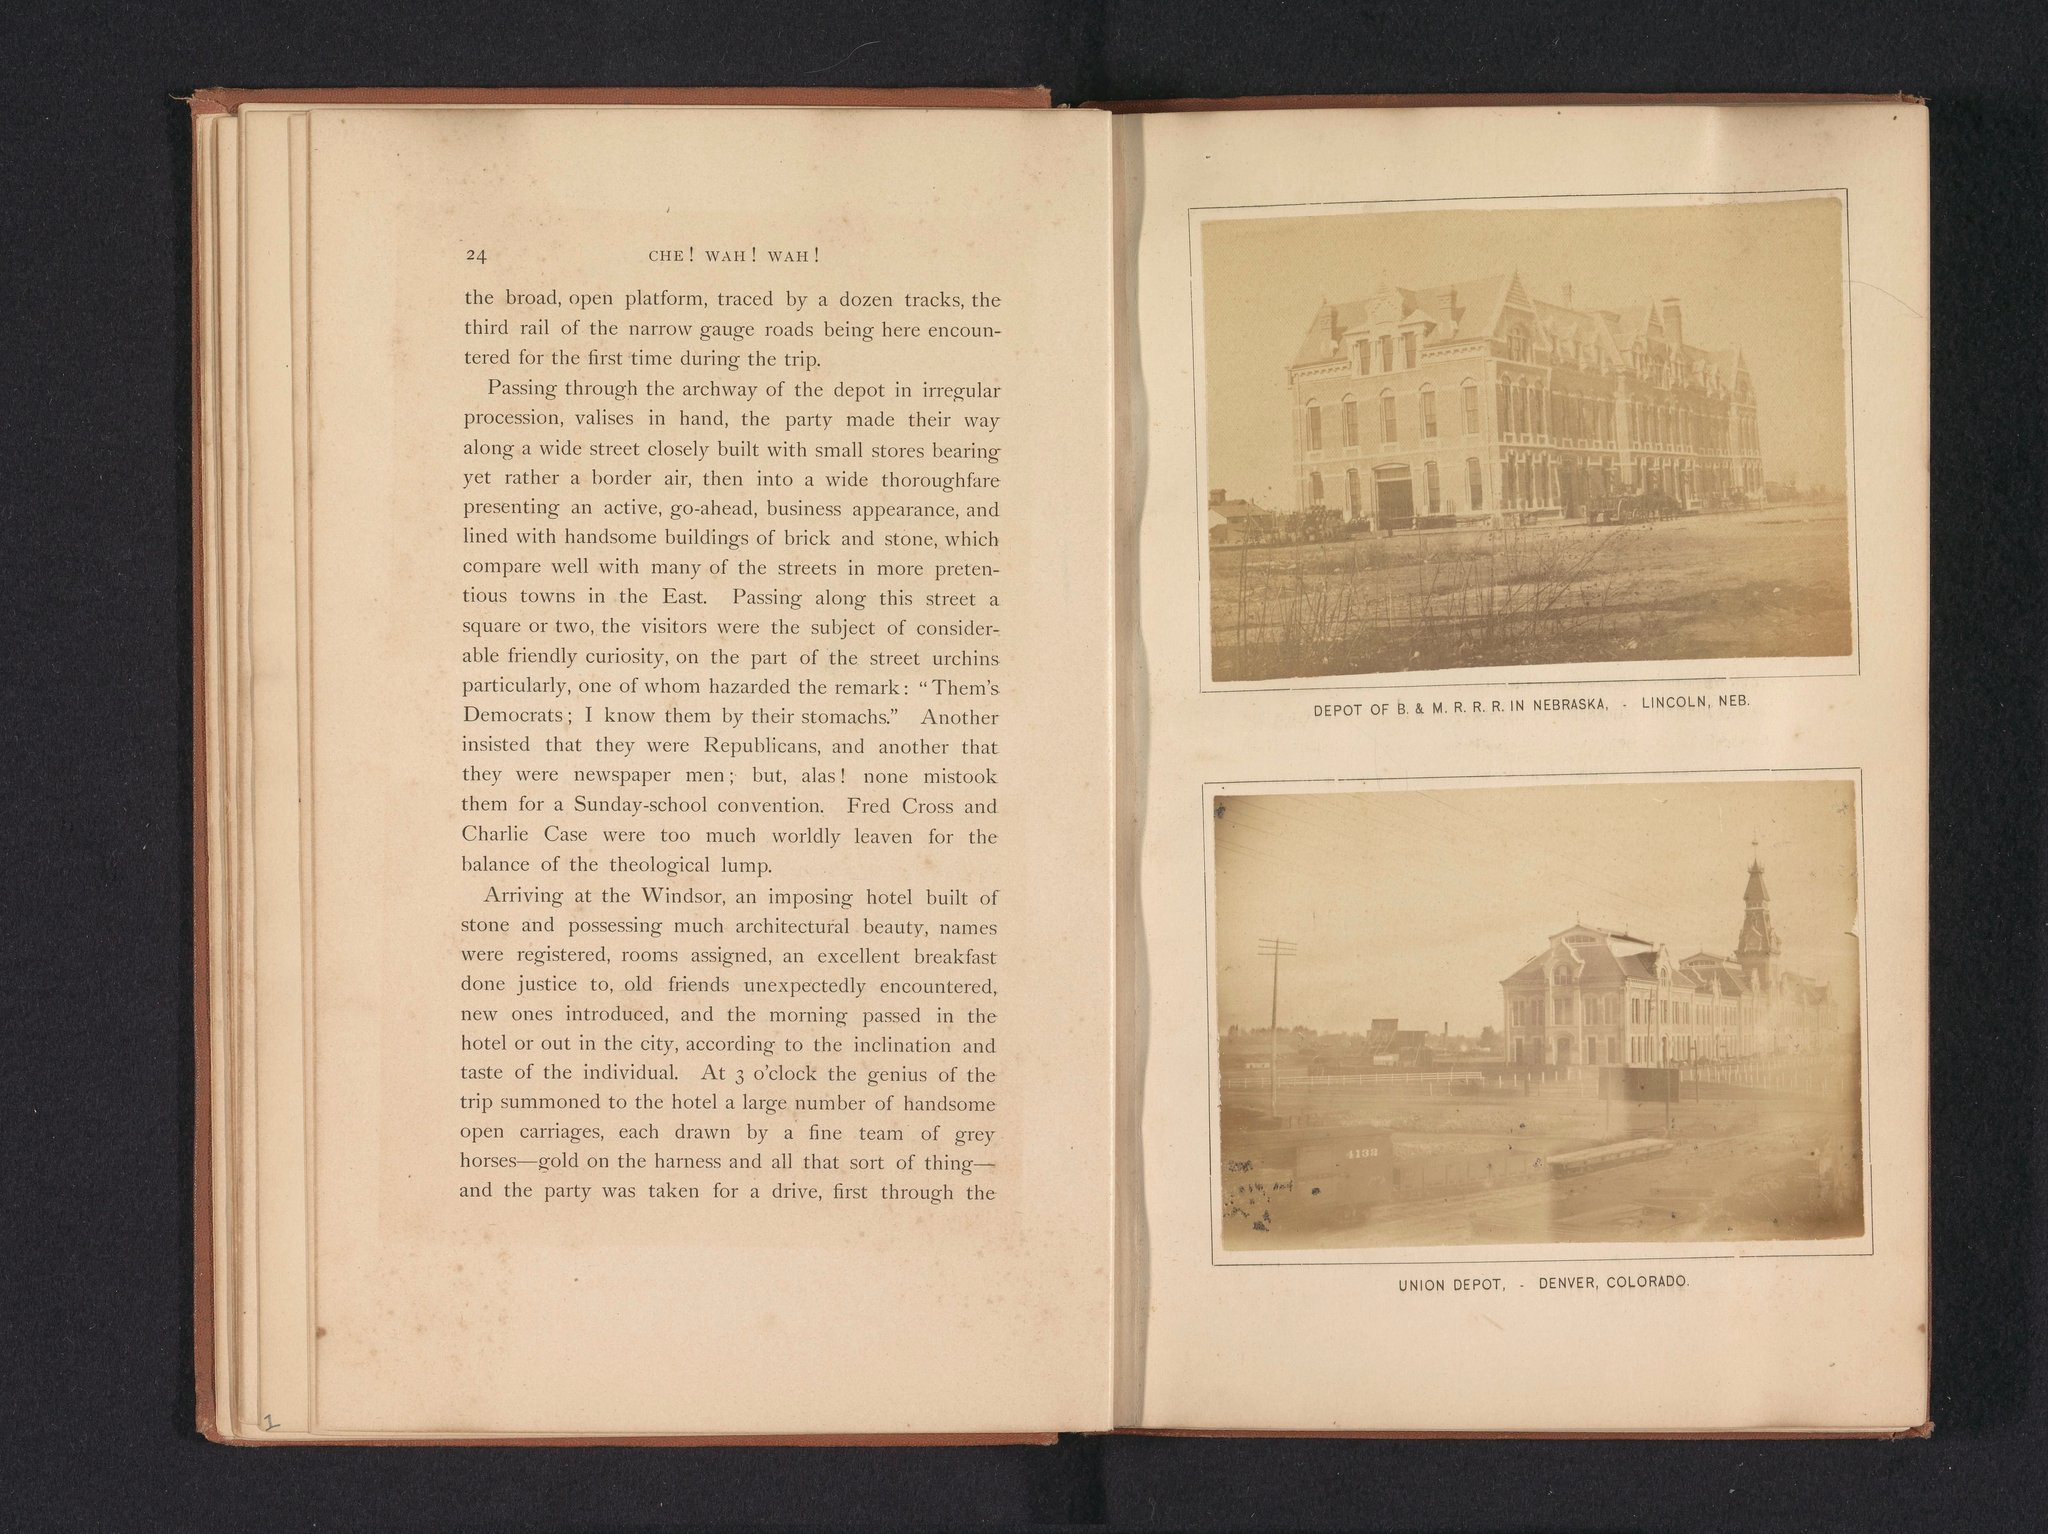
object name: page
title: Treinstations in Lincoln en Denver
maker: r.d. cleveland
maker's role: fotograaf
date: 1873-1883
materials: photographic support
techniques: albumen print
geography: united states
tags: station; shelter (railway, tramway)